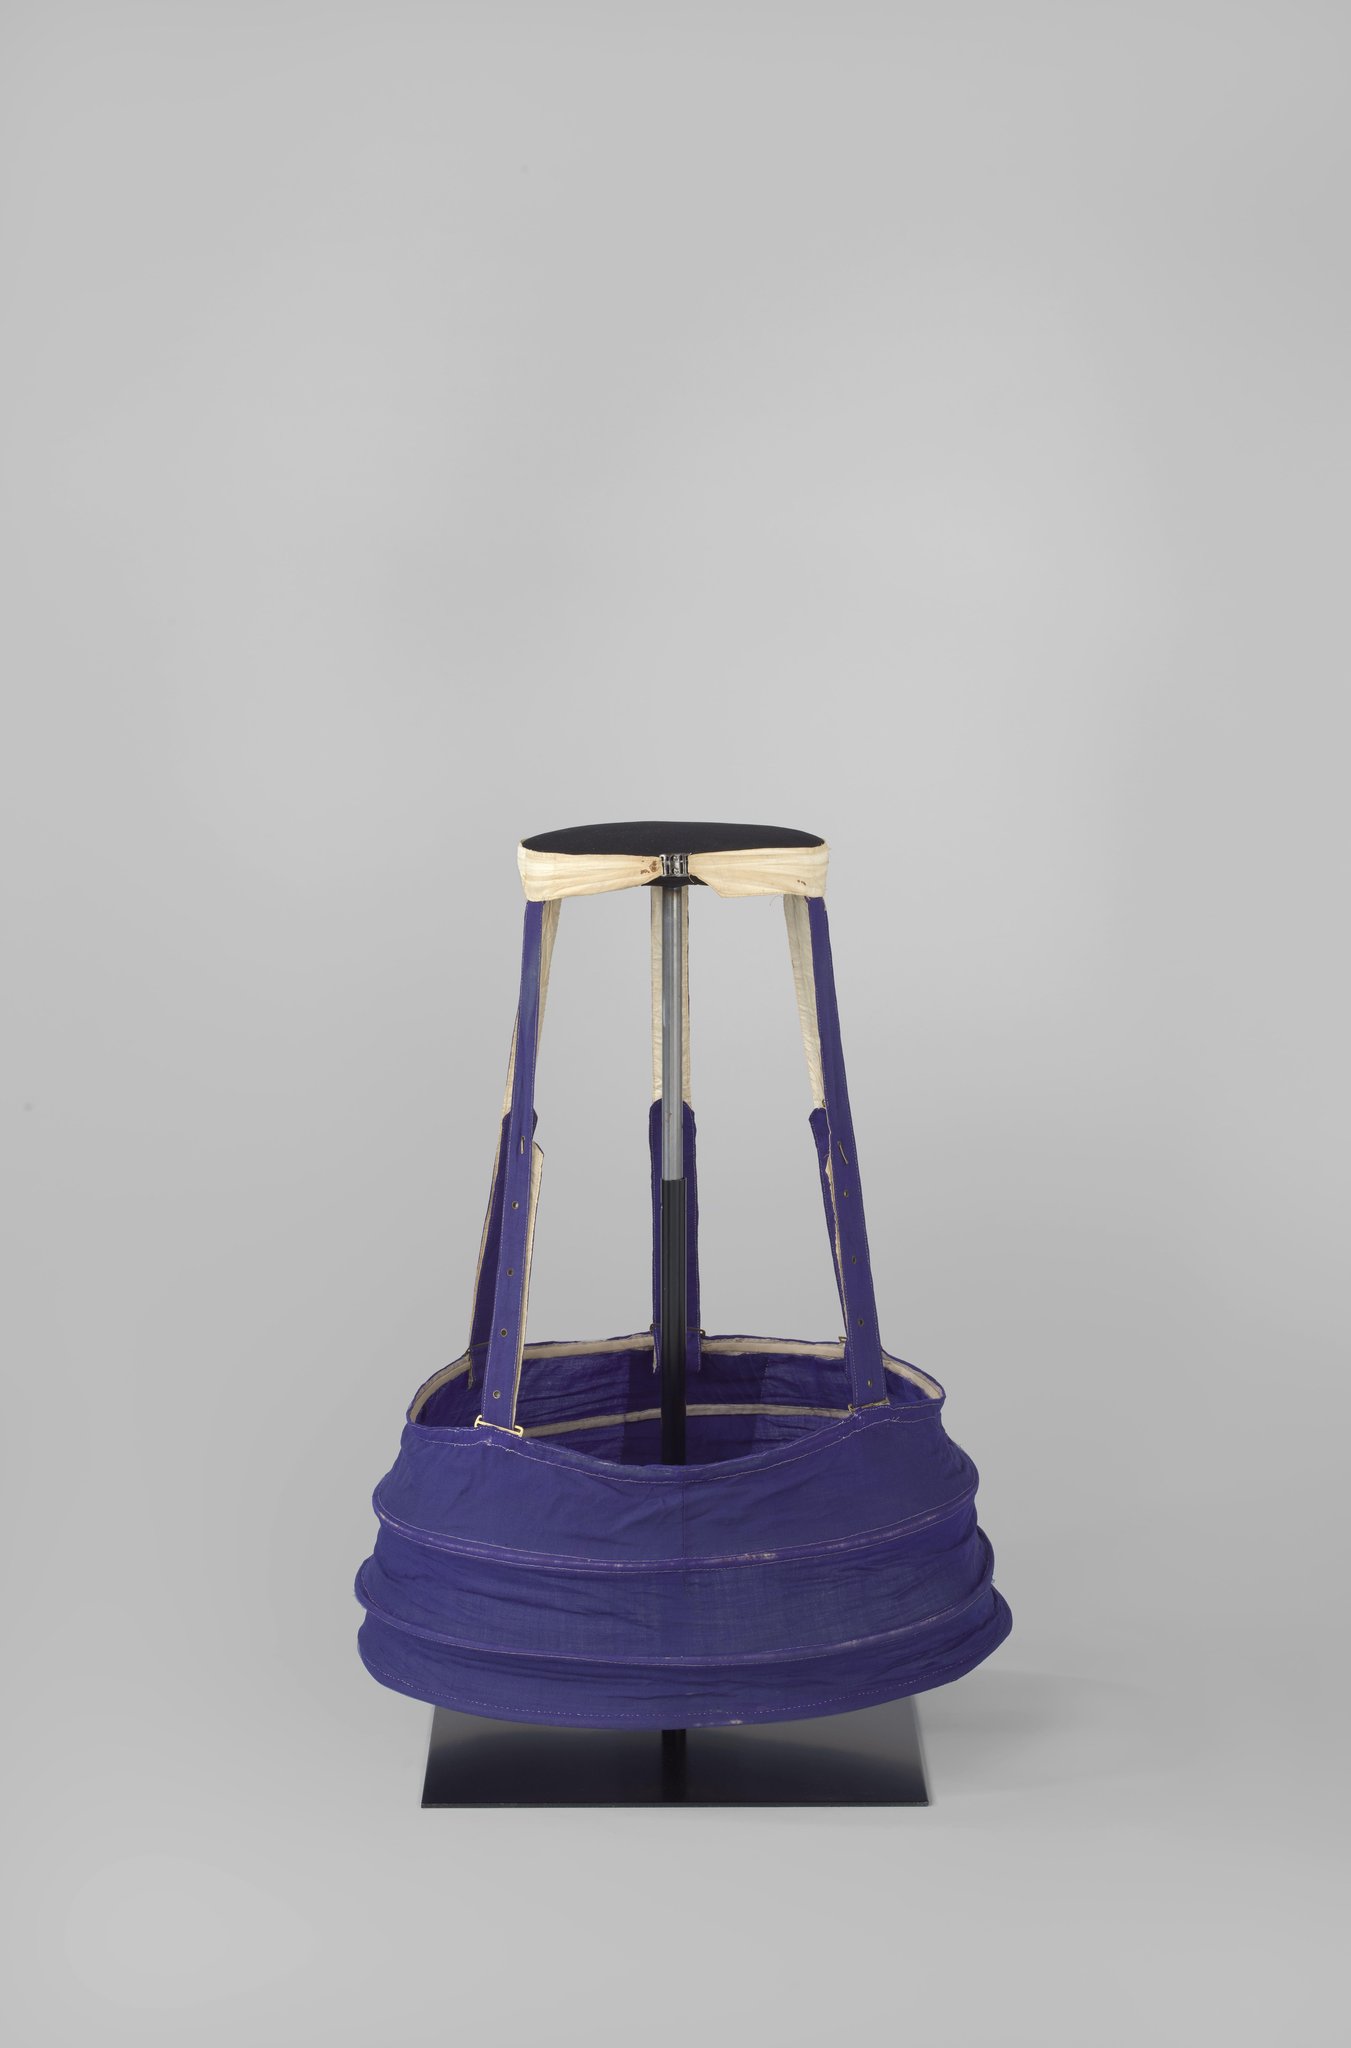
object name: steunende en vormende kleding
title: Crinoline van paars keperkatoen, voorzien van drie baleinen en vijf gespen waaraan evenveel banden bevestigd zijn met zes nestelgaten en een haak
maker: Anonymous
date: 1840-1860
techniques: weave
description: Crinoline van paars keper, voorzien van drie baleinen en vijf gespen waaraan evenveel banden bevestigd zijn met zes nestelgaten en een haak.